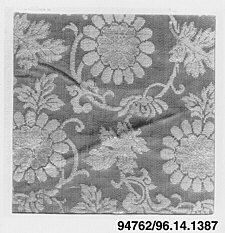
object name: piece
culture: japanese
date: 1701-1900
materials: silk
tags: flowers